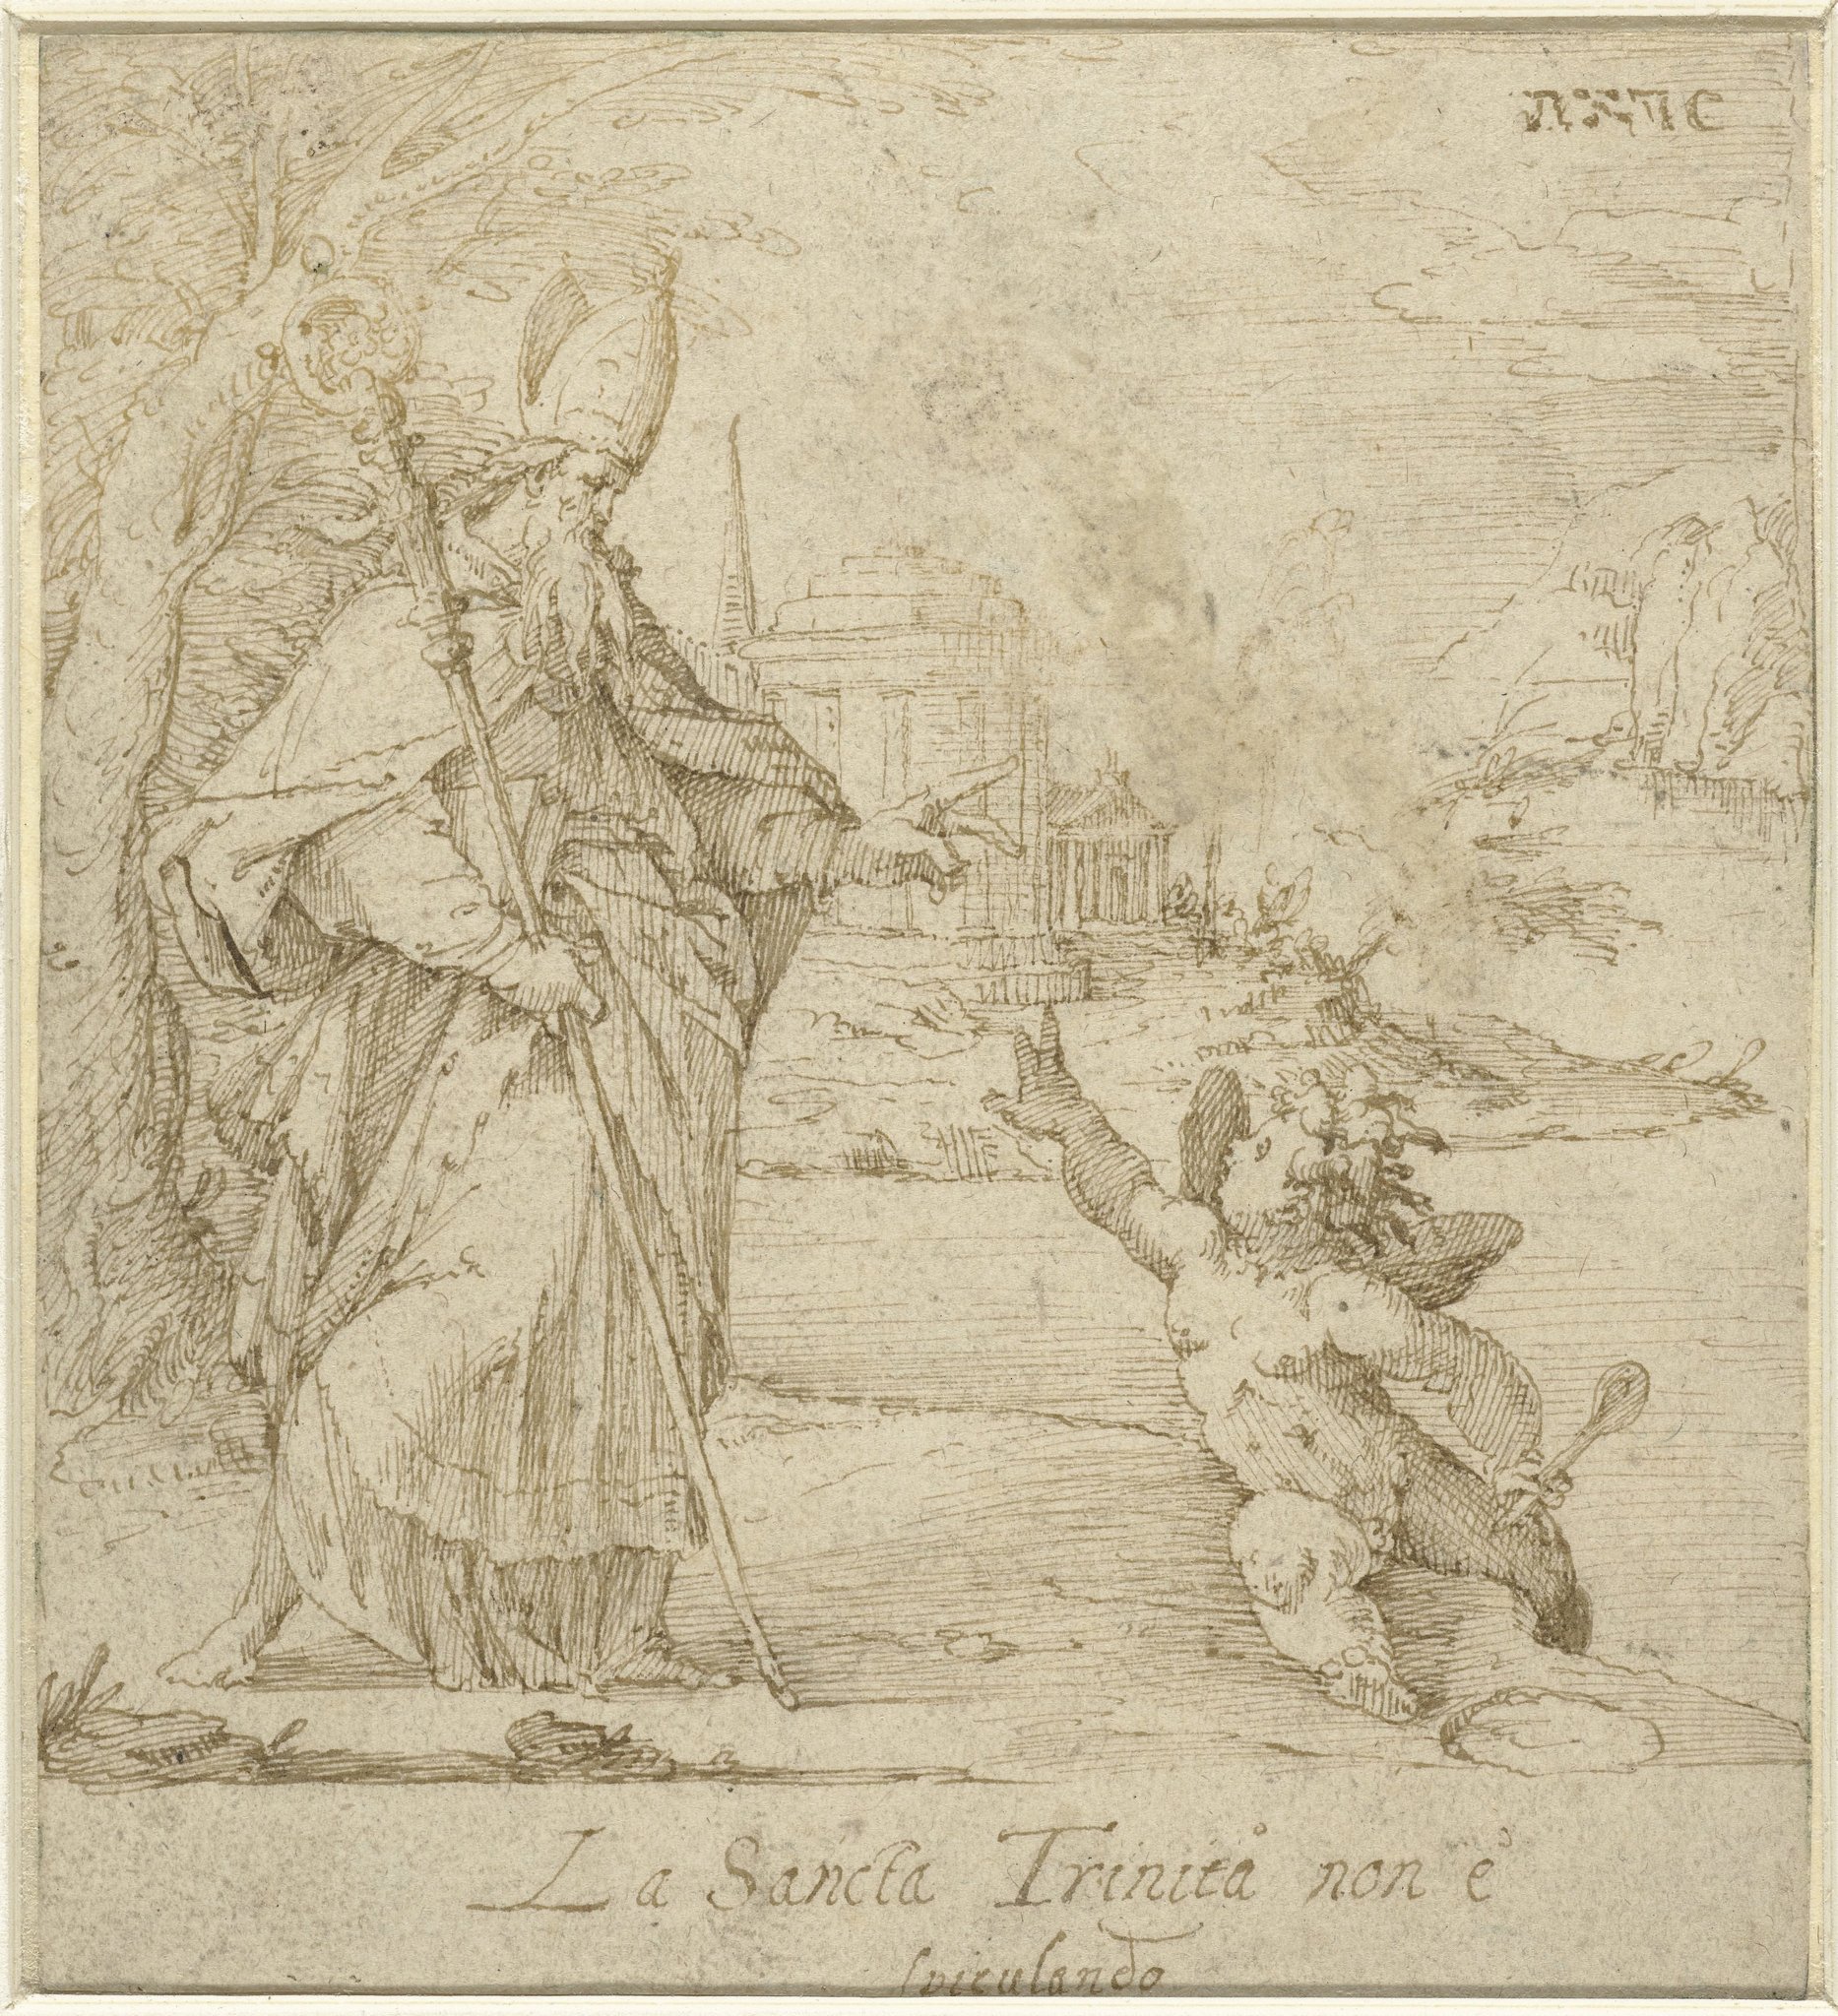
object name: drawing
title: Heilige Augustinus in gesprek met het kind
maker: Anonymous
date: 1500-1599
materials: ink, paper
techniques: pen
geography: northern italy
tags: st. augustine walking by the sea-shore, meditating on the trinity; he comes upon a child, who has made a hole in the sand and in vain tries to fill it with water with the aid of a shell or a spoon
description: Heilige Augustinus in gesprek met het kind aan de oever van de zee.